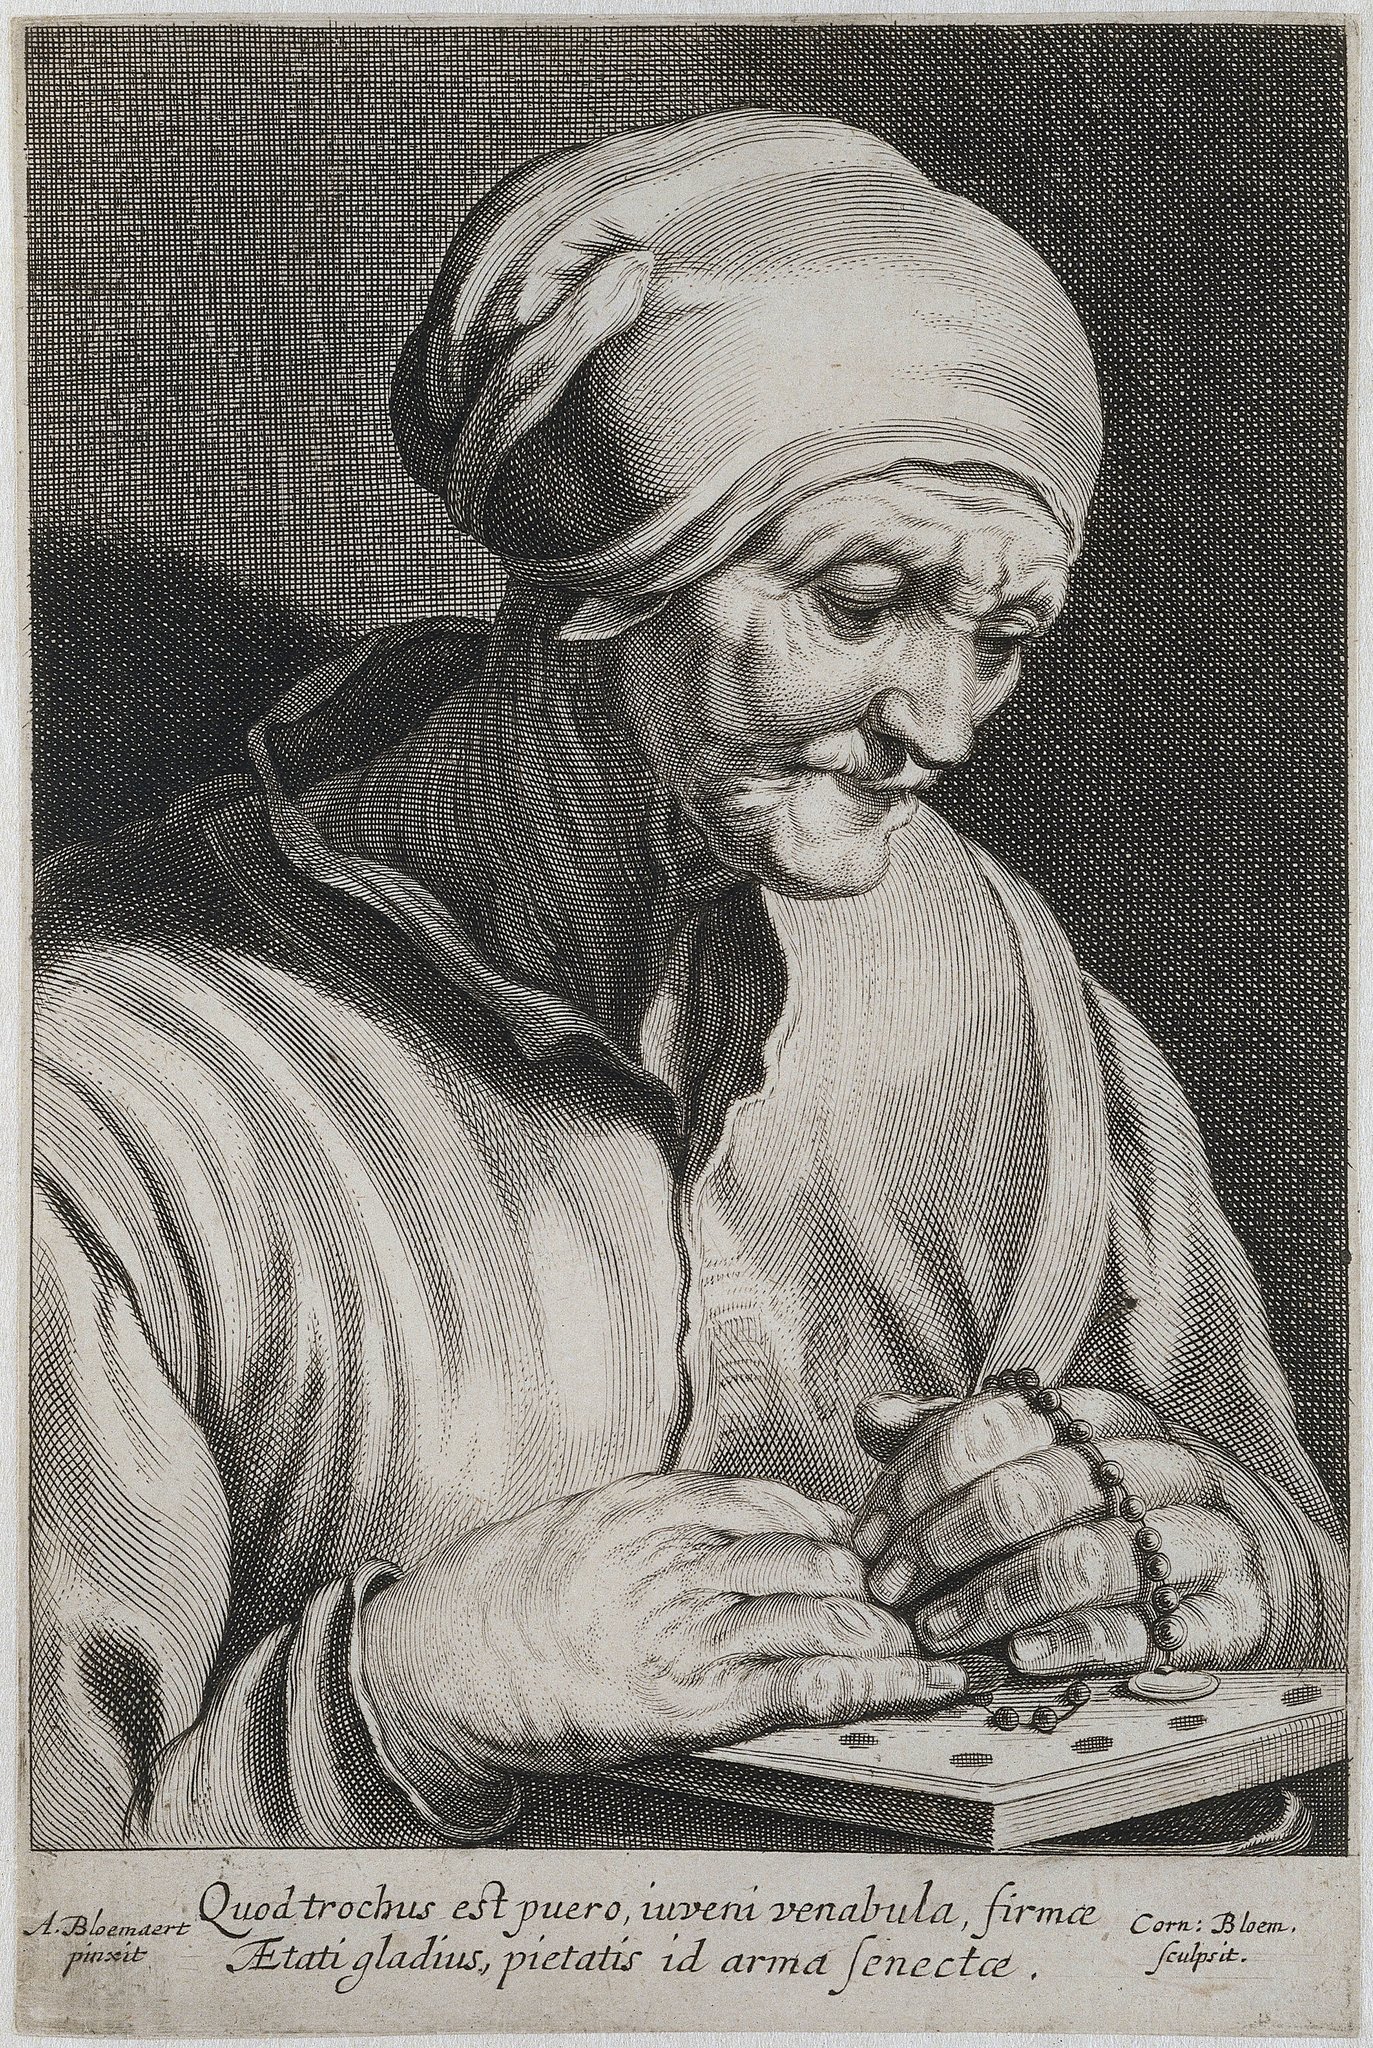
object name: print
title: Oude vrouw met rozenkrans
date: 1625-1630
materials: paper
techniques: engraving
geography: utrecht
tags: the (nude) human figure; 'corpo humano' (ripa) (+ old female (human being)), saying the rosary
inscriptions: collector's mark: Lugt 240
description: Een oude vrouw die haar handen boven een stoof warmt, biddend met een rozenkrans tussen de vingers. Met tweeregelig Latijns vers.